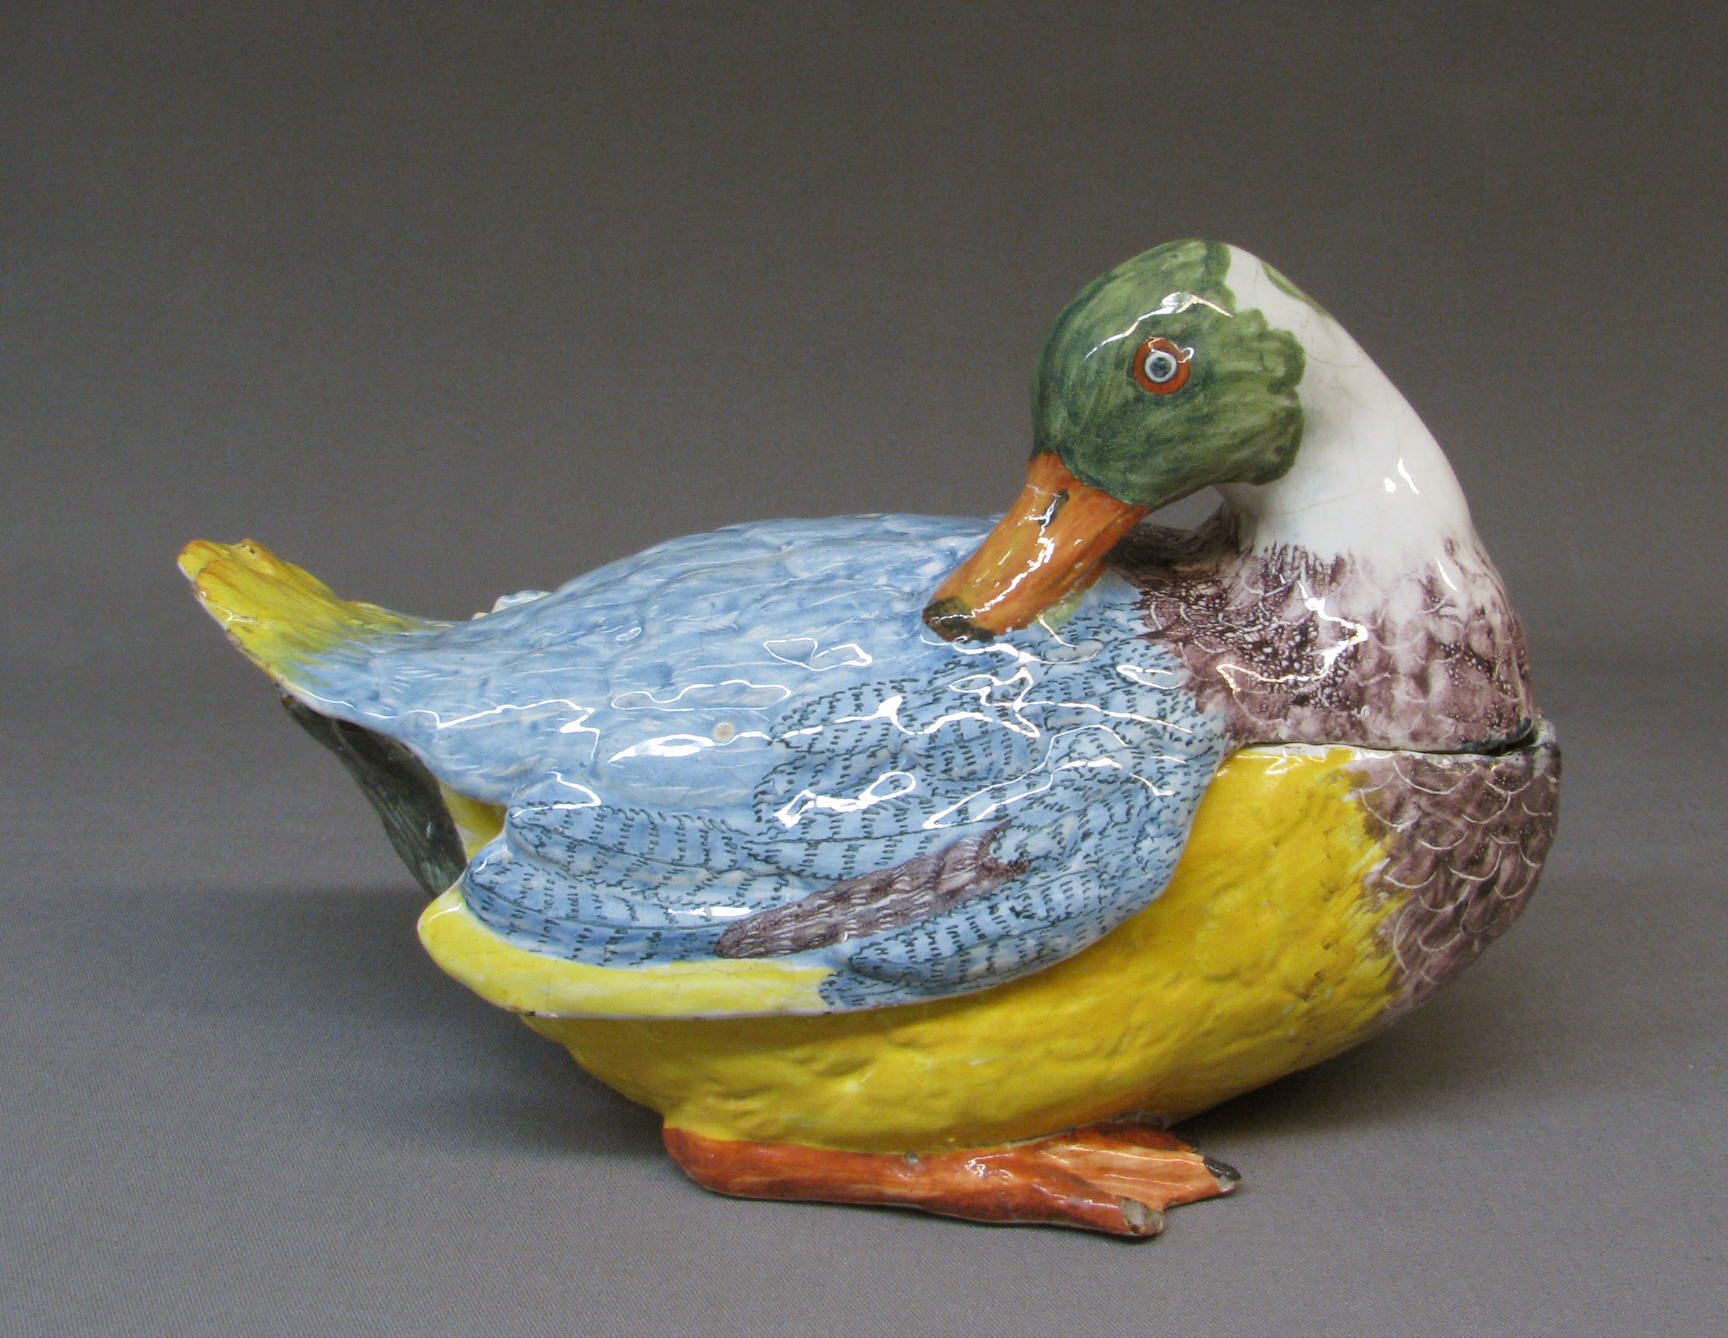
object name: tureen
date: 1750-1760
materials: earthenware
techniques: glazing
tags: ducks